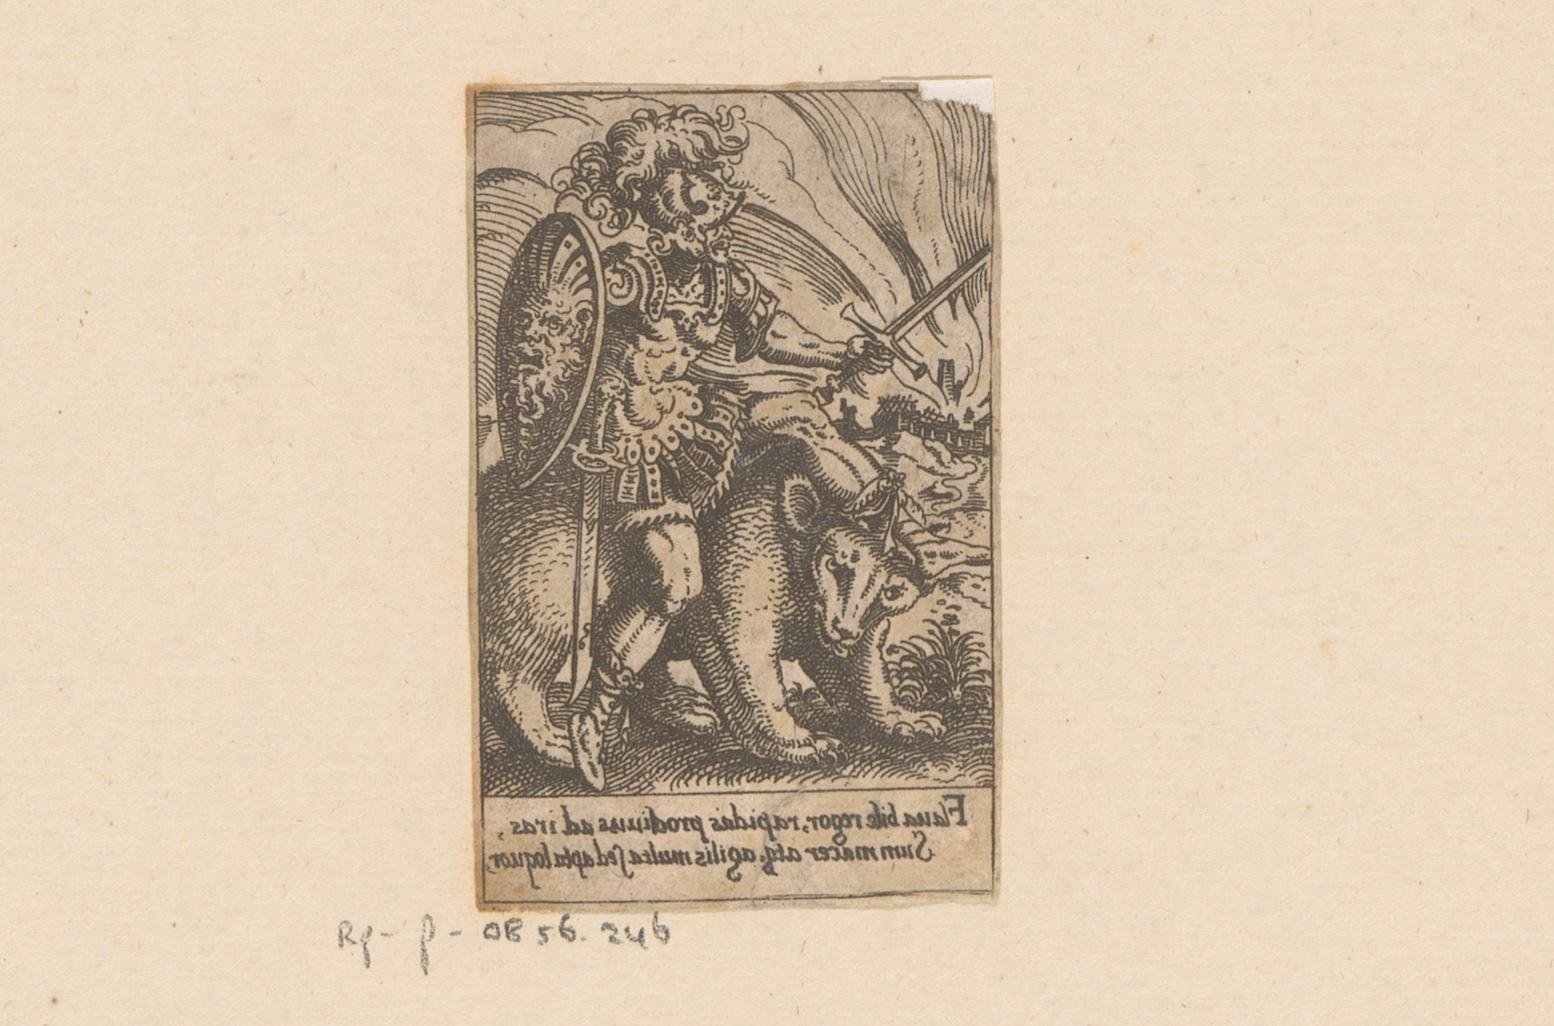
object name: print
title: Cholerisch temperament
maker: Anonymous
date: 1549-1591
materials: paper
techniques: etching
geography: germany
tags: choleric temperament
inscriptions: collector's mark: Lugt 2228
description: Gespiegelde versie van een serie van vier prenten van Jost Amman.